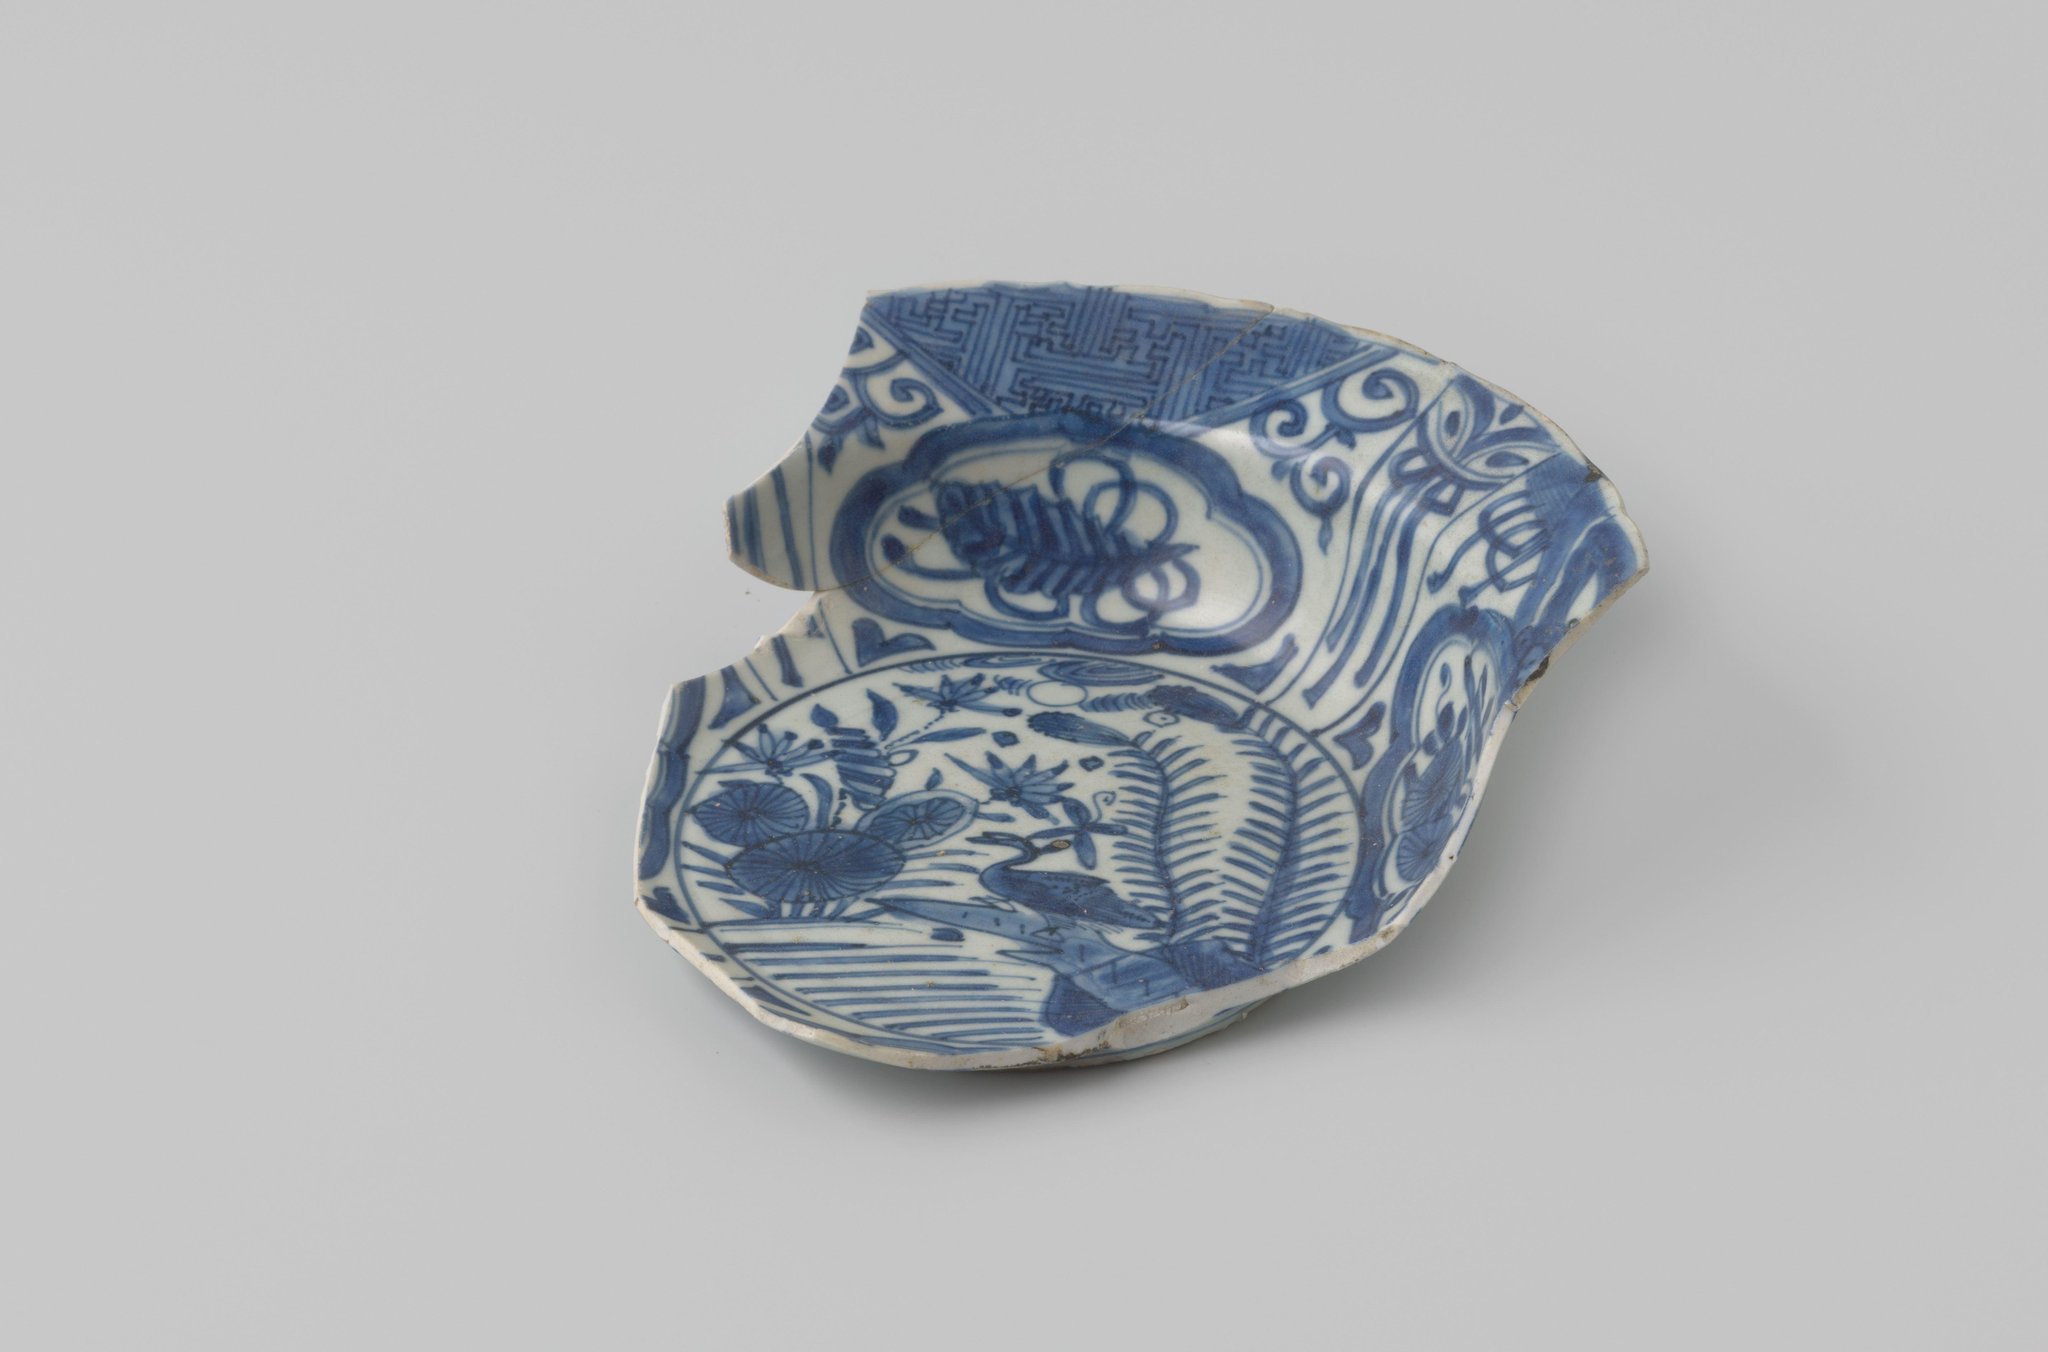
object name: deep dish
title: Fragment diep bord uit V.O.C.-schip de 'Witte Leeuw'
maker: Anonymous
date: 1613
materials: bone china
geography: jingdezhen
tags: verenigde oostindische compagnie, sint-helena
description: A bowl with a flattened rim. Taotie mask and/or borders with diaper patterns. A central decoration of a grasshopper on a rock next to a peony. Panels decorated with flowers and fruits.